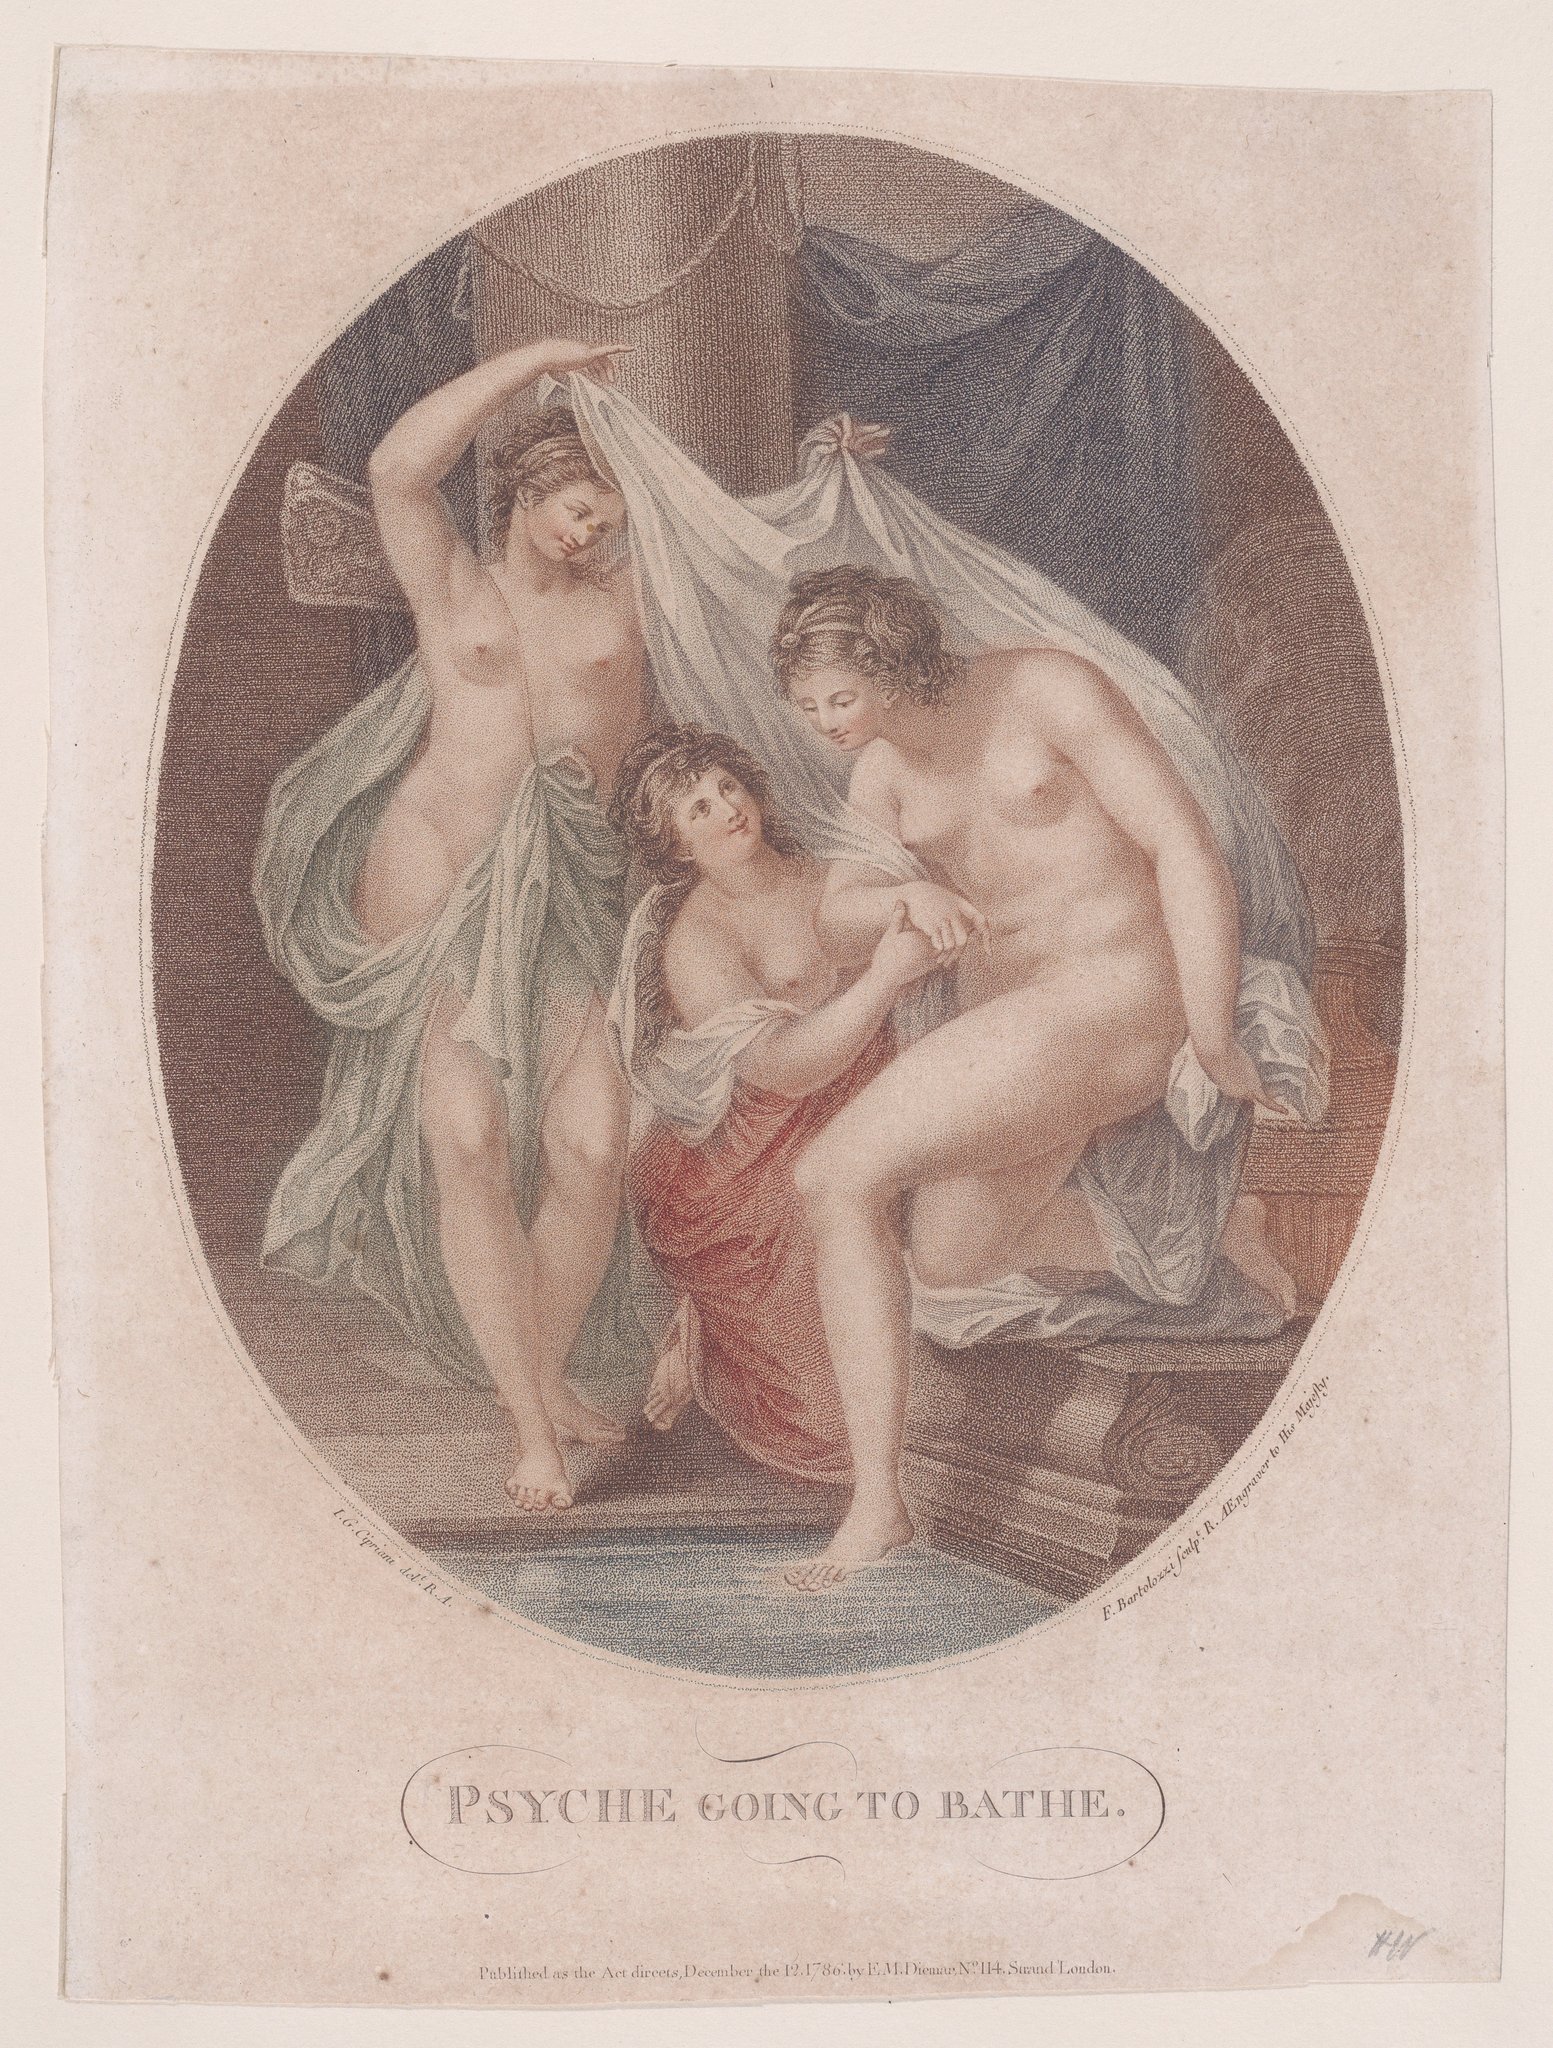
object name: print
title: Psyche Going to Bathe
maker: francesco bartolozzi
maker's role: artist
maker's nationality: italian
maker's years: 1728-1815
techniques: etching, printing, engraving